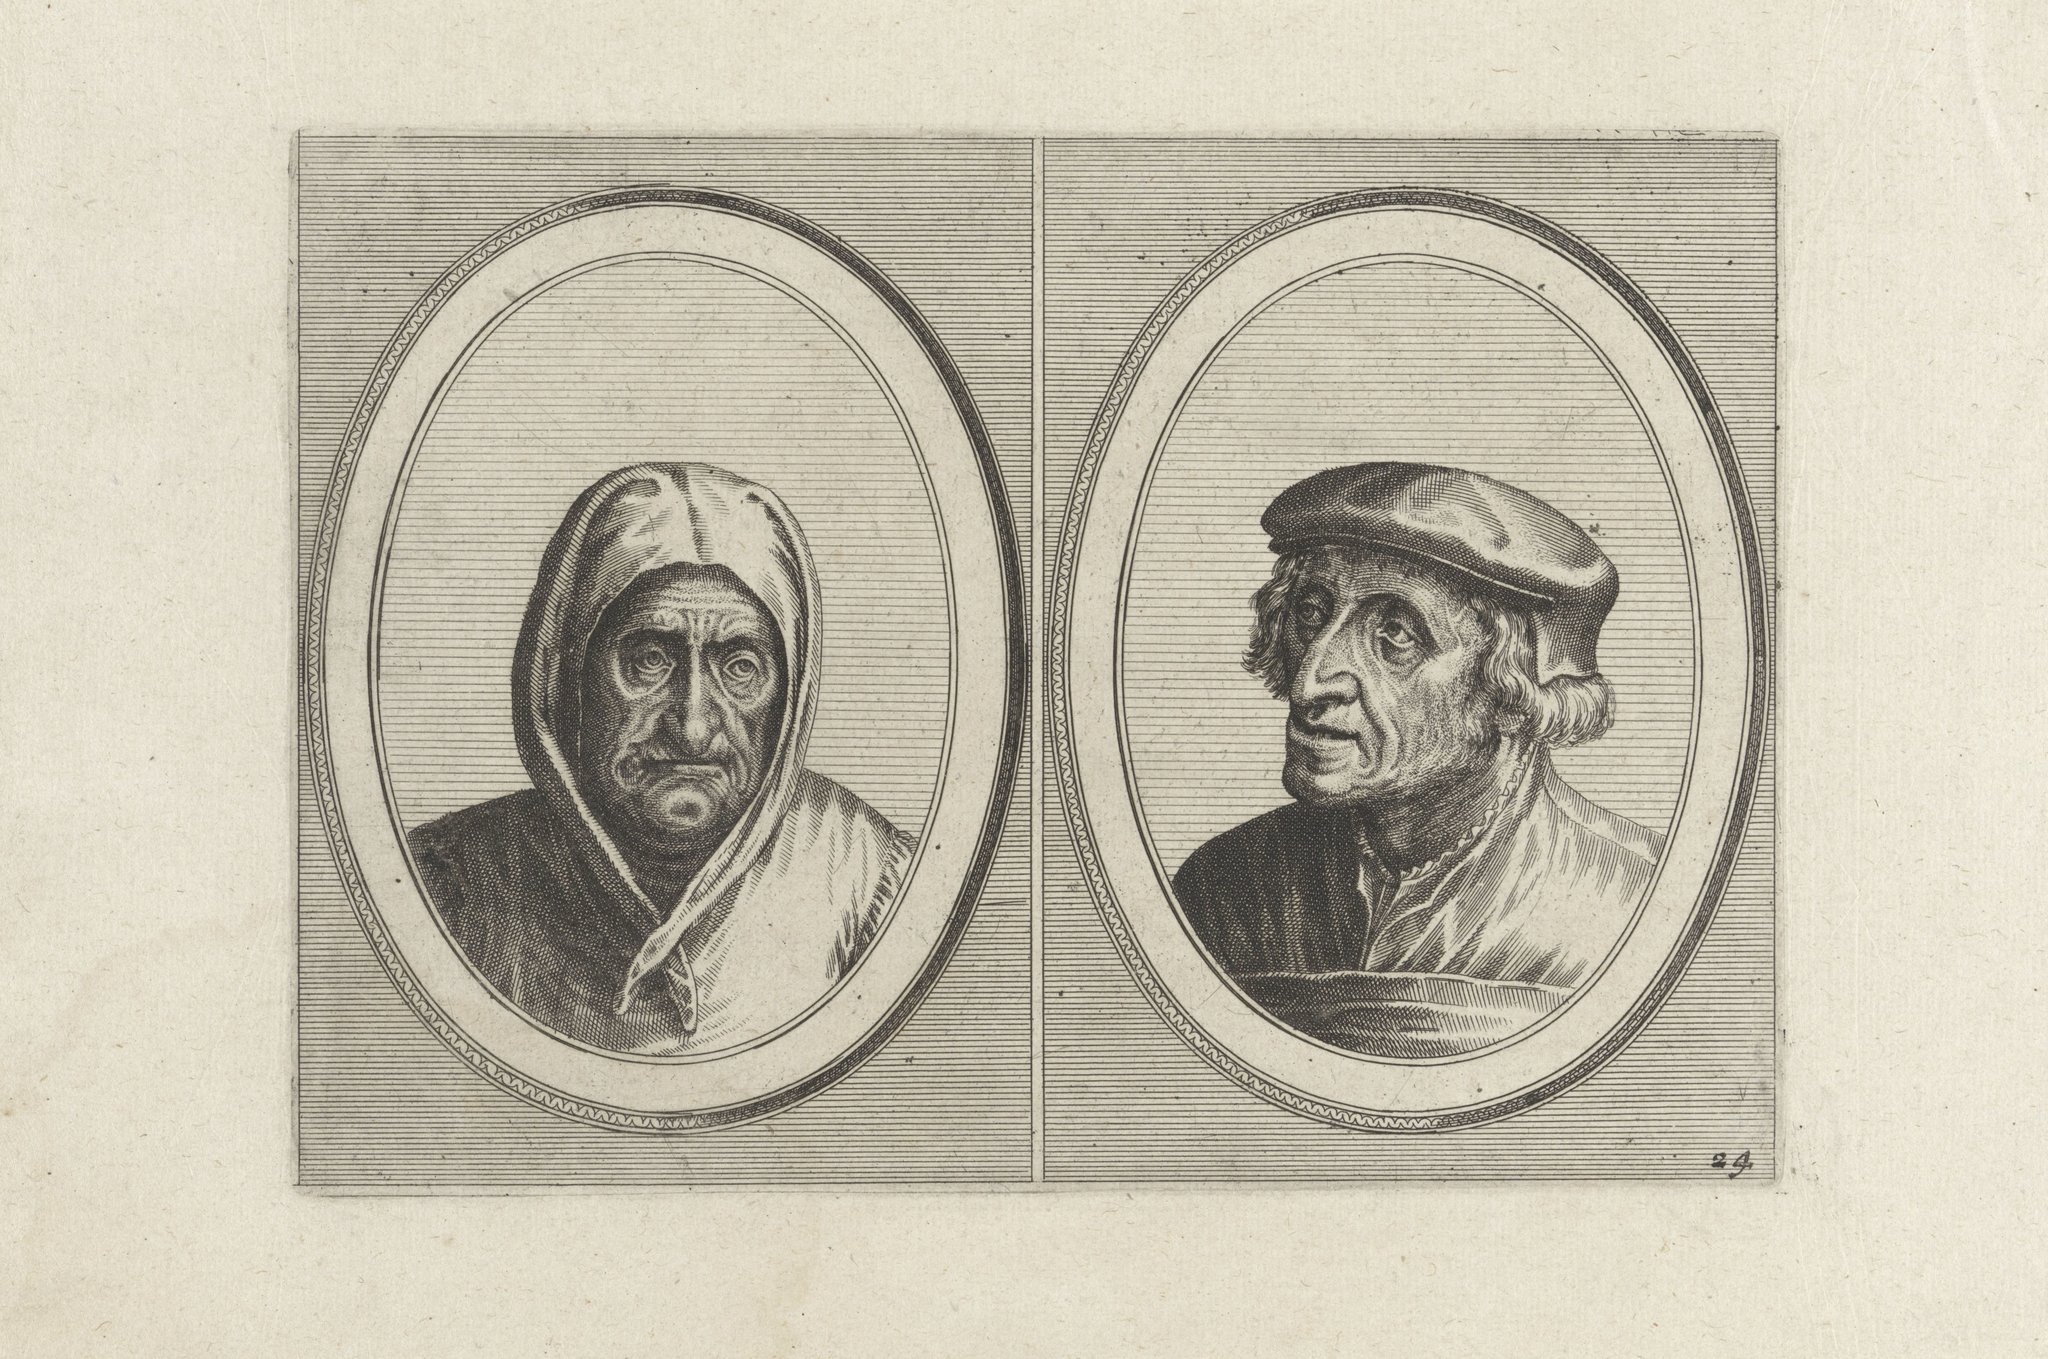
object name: print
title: Boerenkoppen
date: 1612-1652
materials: paper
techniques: engraving, etching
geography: amsterdam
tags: head-gear, farmers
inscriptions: collector's mark: Lugt 700, collector's mark: Lugt 240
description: Prent uit een serie van 36 prenten met koppen van boeren en boerinnen.